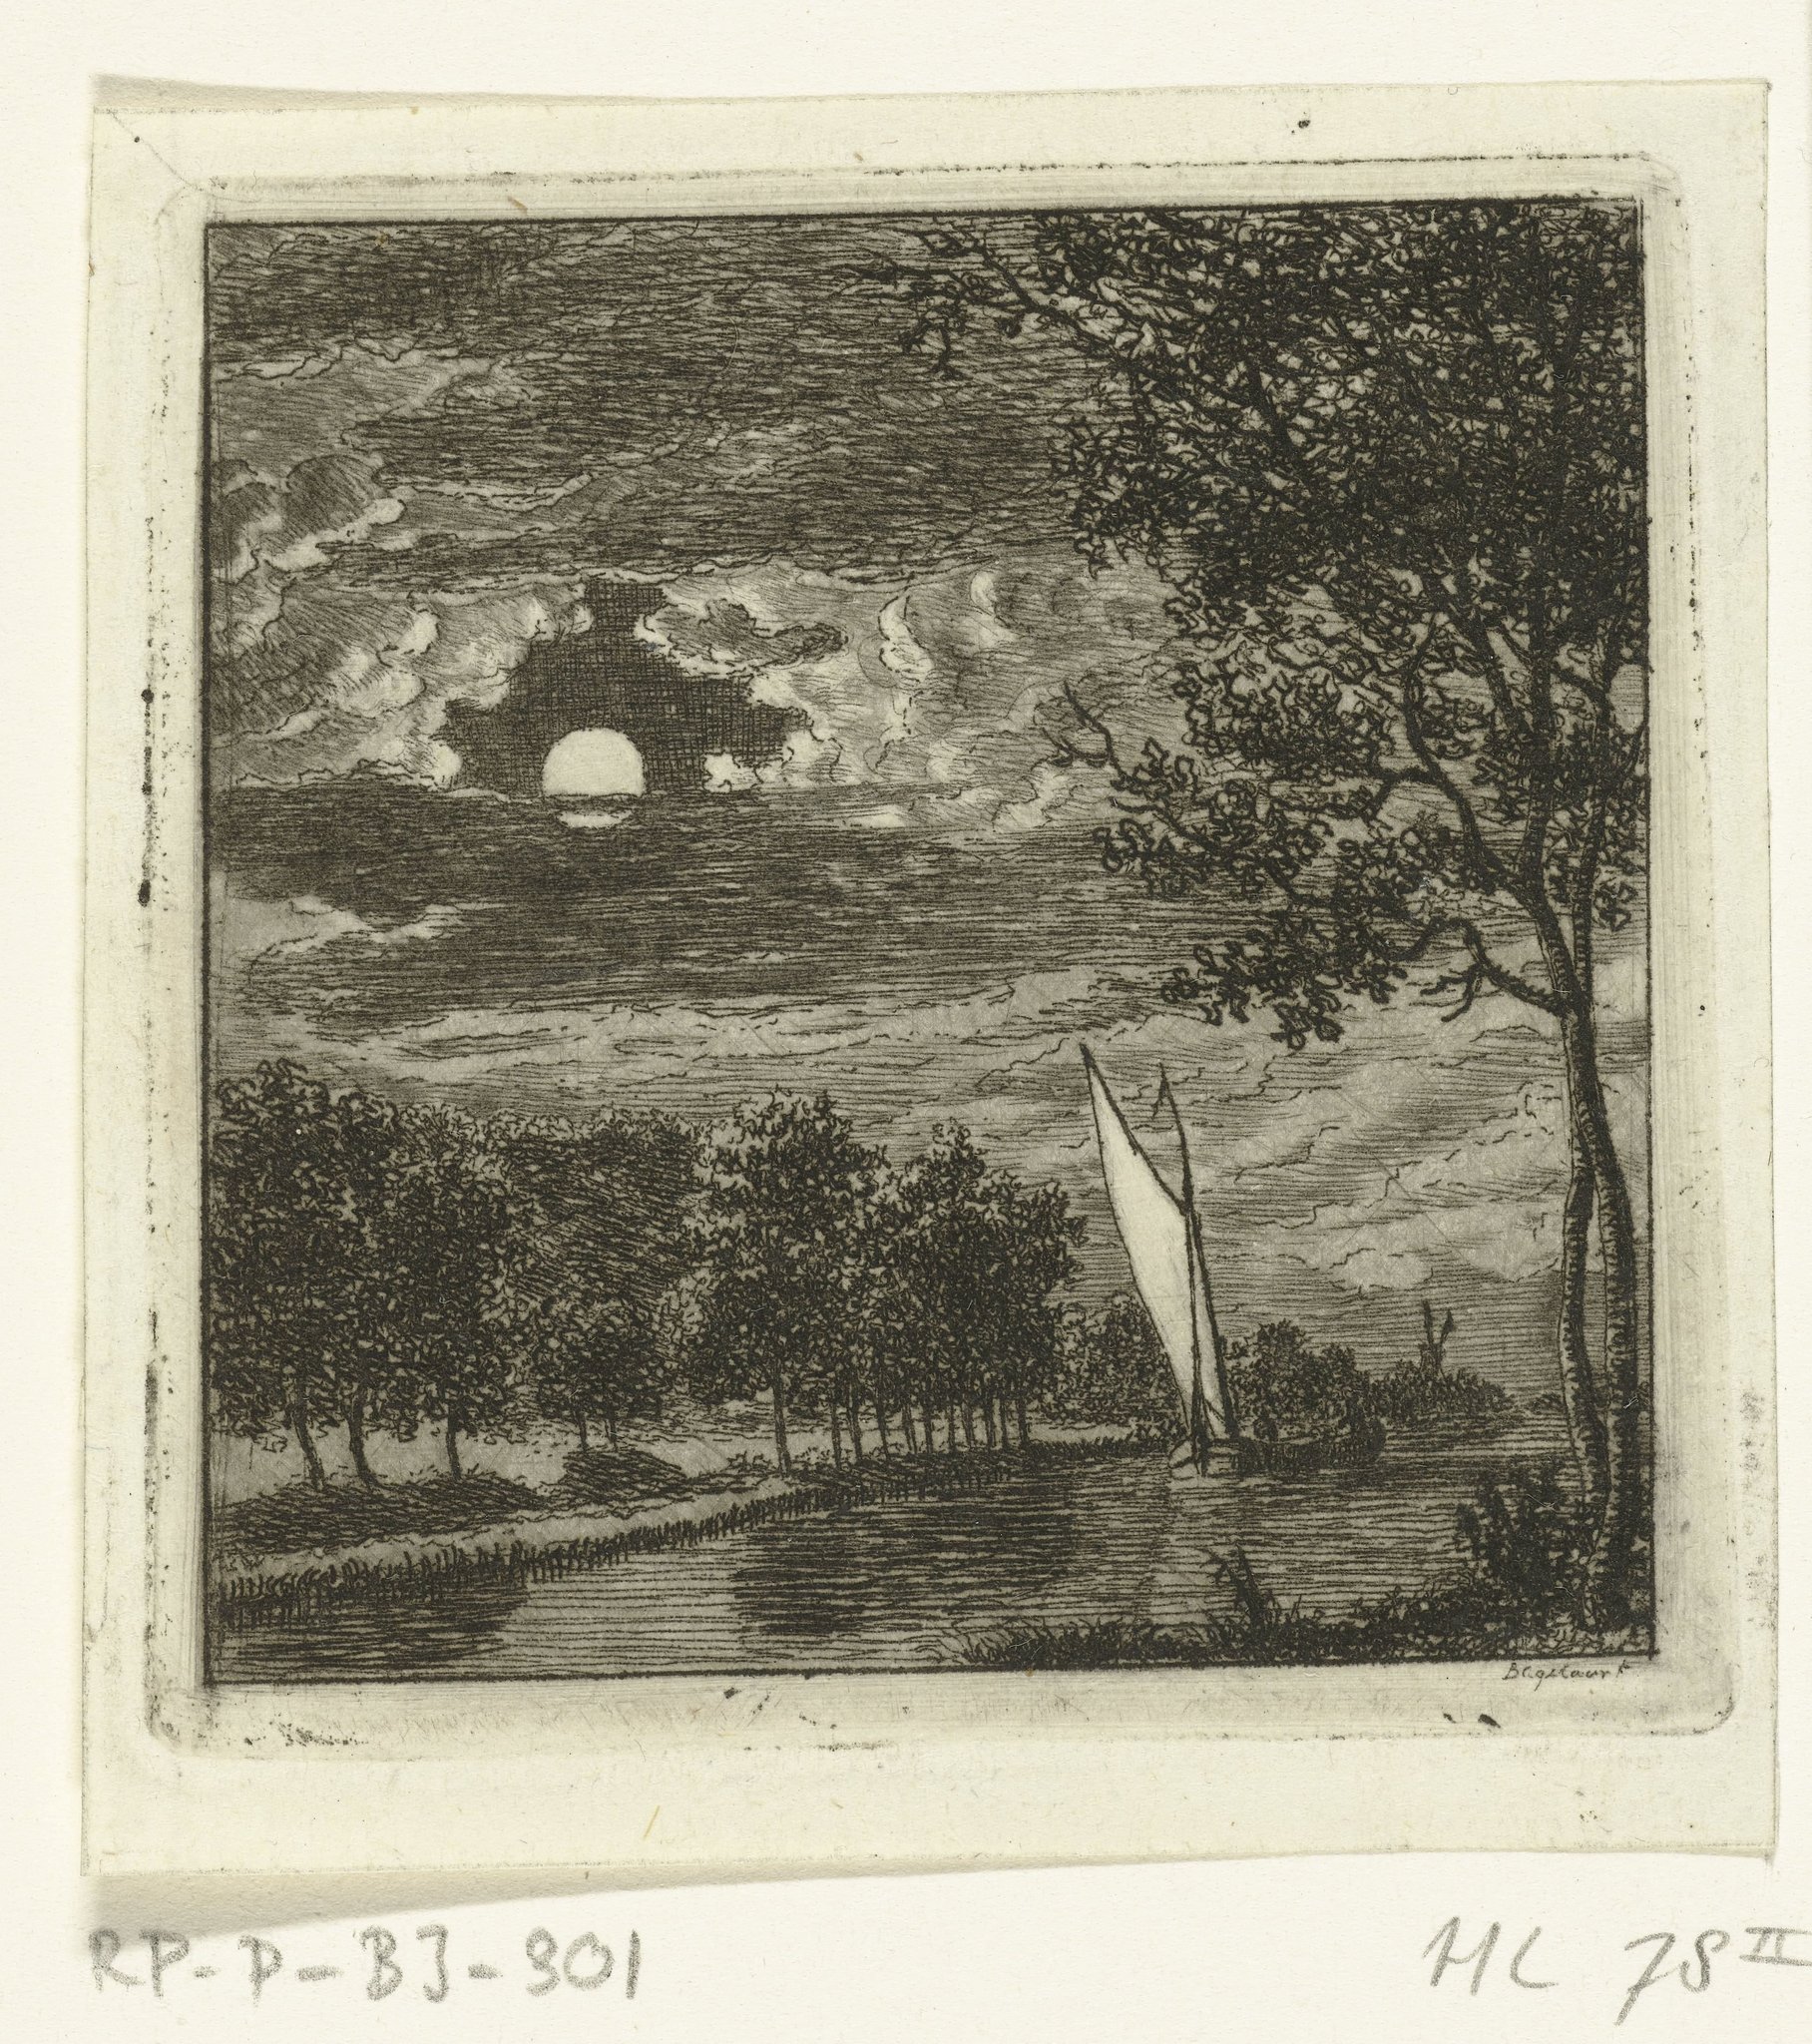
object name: print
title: De Delftsevaart bij het molentje bij nacht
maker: ernst willem jan bagelaar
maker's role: draughtsman, print maker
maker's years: 1775-1837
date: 1798-1837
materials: paper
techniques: drypoint, etching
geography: netherlands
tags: landscapes with waters, waterscapes, seascapes (in the temperate zone)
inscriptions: collector's mark: Lugt 2228